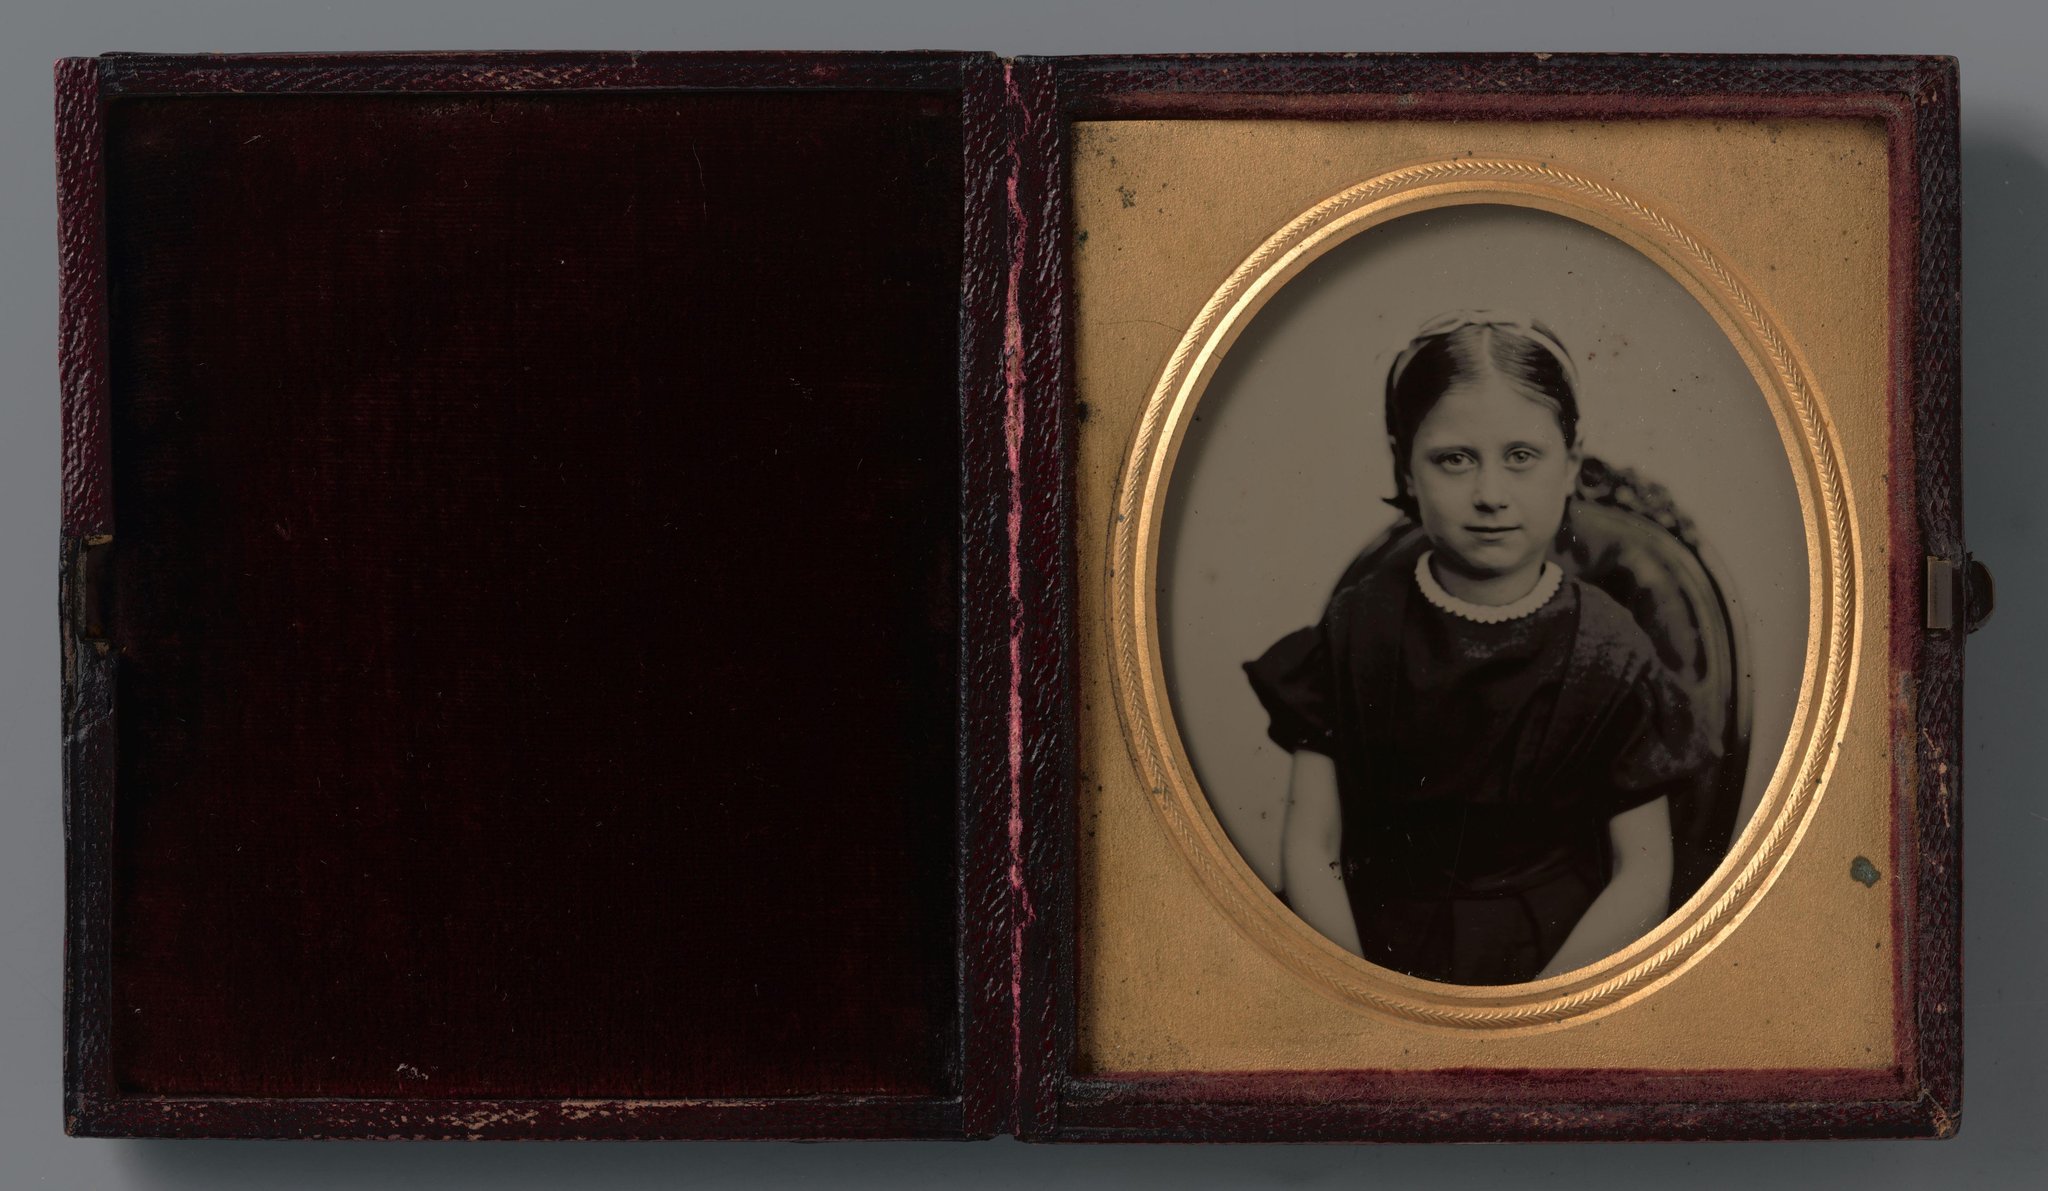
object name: photograph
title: Portret van een onbekend meisje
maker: Anonymous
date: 1840-1860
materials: glass, leather, metal, velvet, wood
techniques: ambrotype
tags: sitting figure - aa - female human figure, historical persons - bb - woman, girl (child between toddler and youth)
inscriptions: inscription: ‘MAYALL/ 224 REGENT St/ Argyll place/ LONDON’, inscription: ‘Houdet, 145 Rue St. Honore’